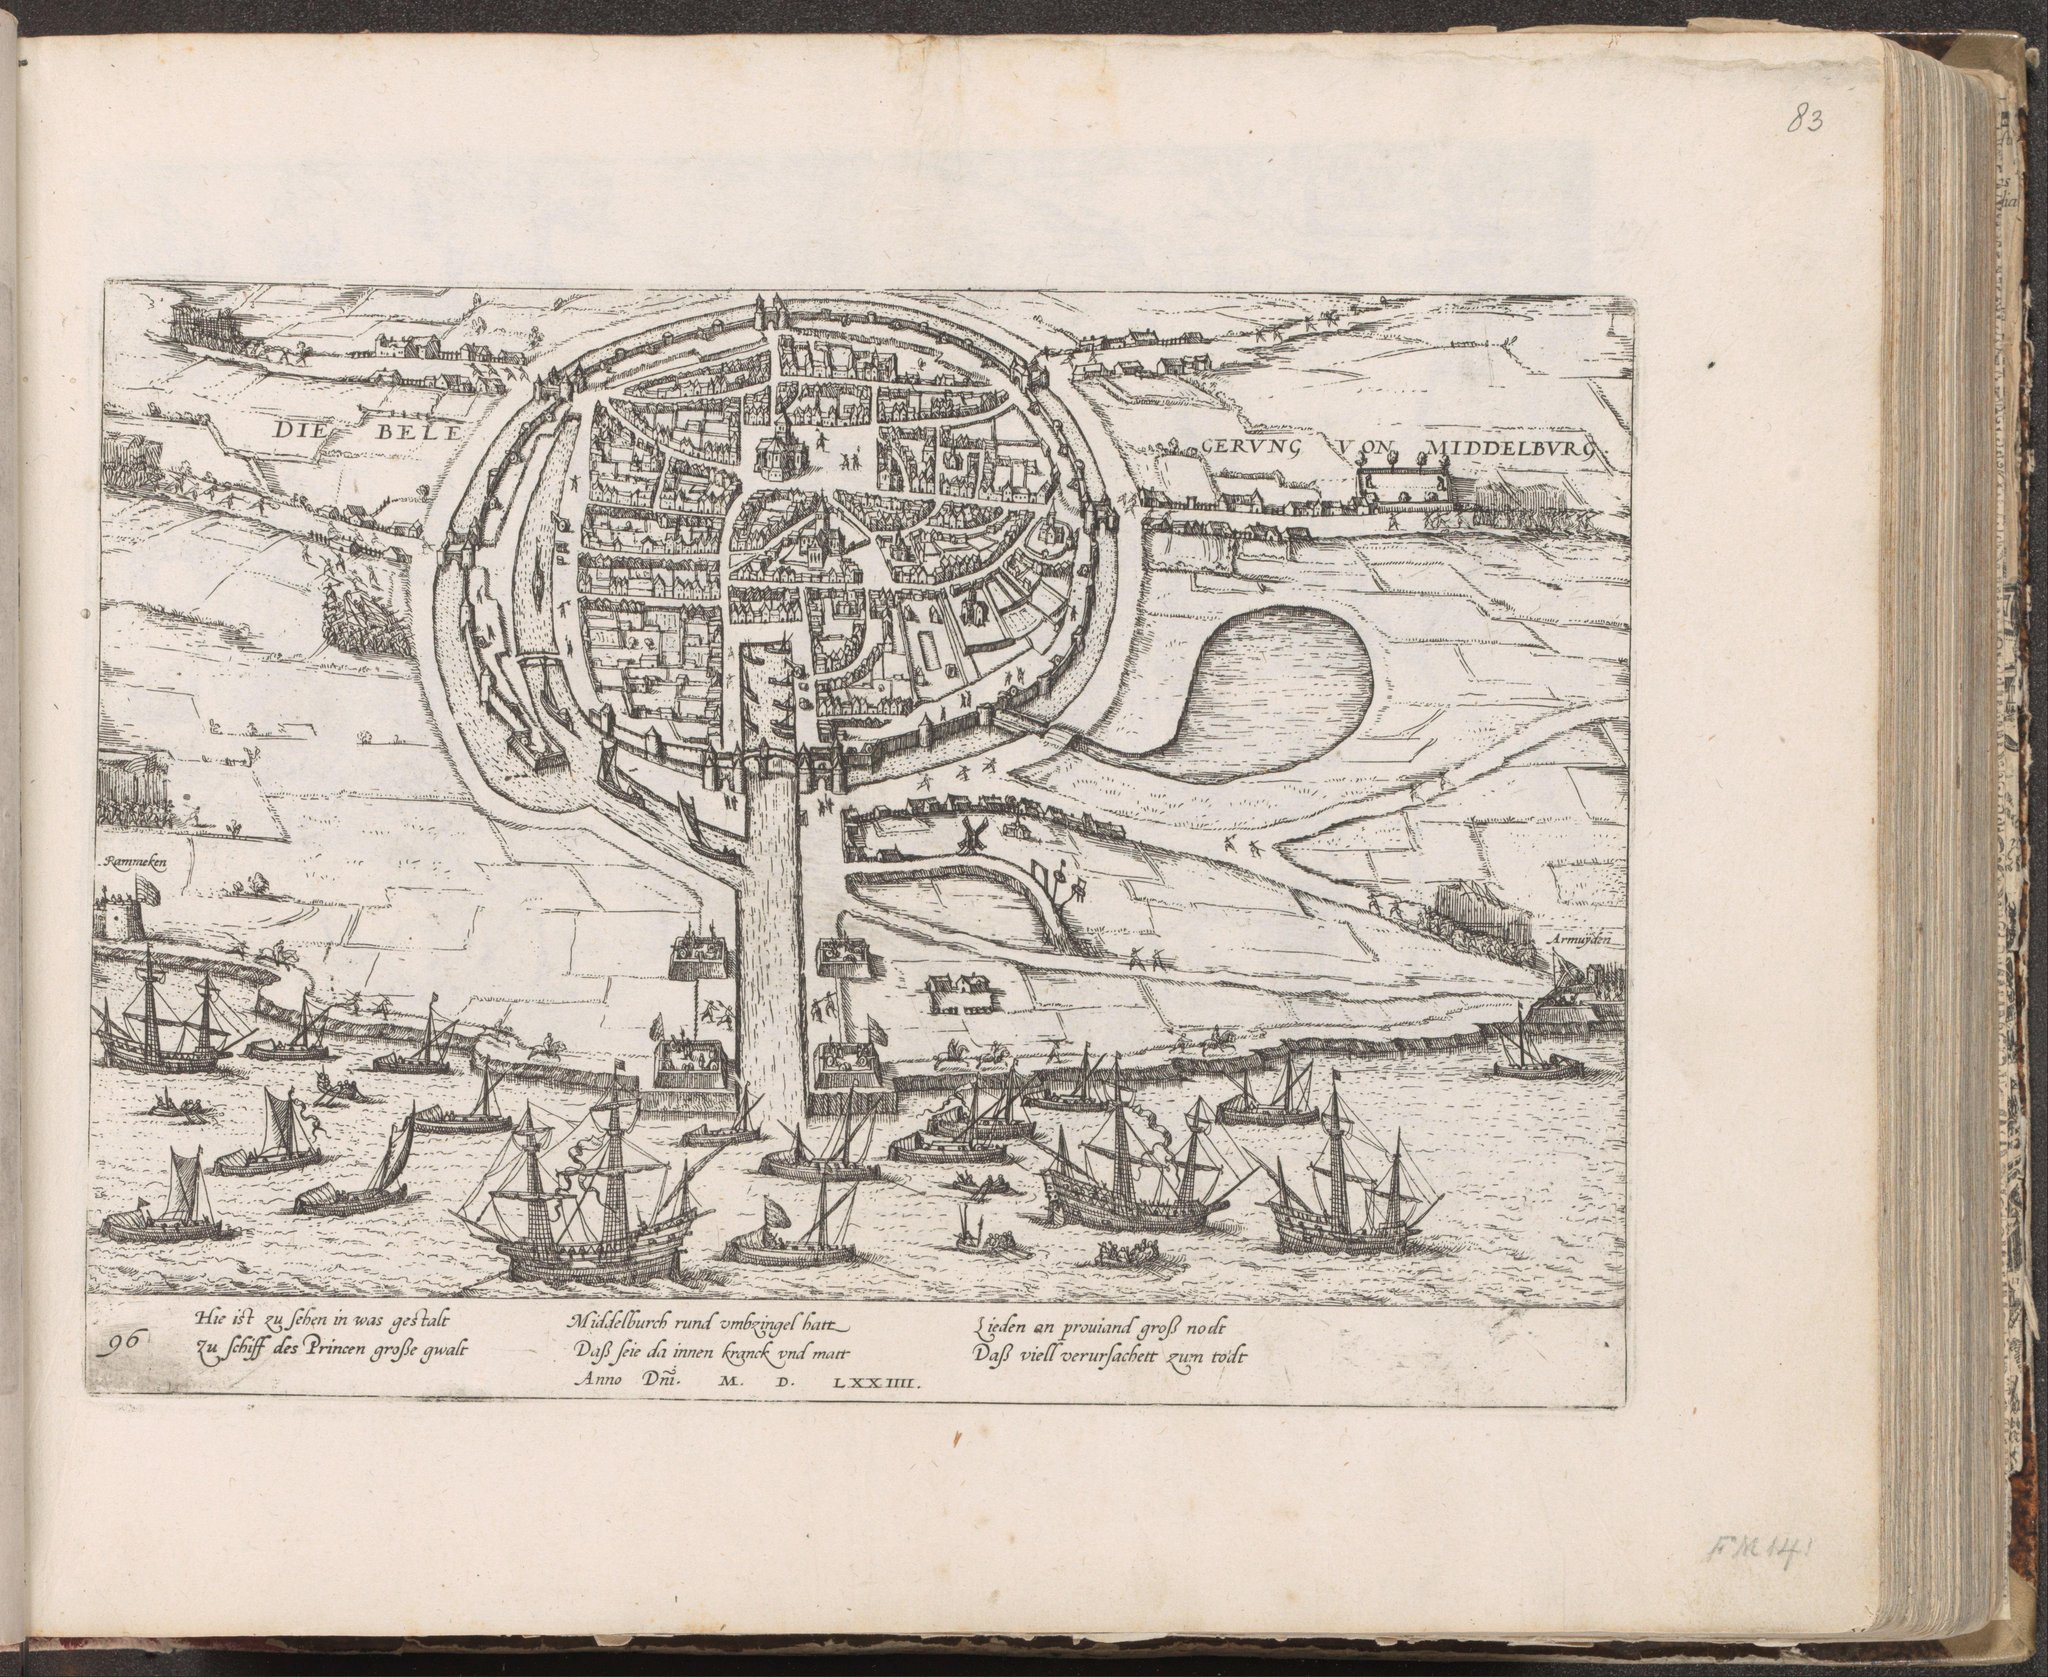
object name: print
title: Serie 6: Nederlandse Gebeurtenissen, 1571-1576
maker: frans hogenberg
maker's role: print maker, publisher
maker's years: 1538-1590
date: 1574-1578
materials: paper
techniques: etching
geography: cologne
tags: siege, position war, middelburg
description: Beleg van Middelburg door de opstandelingen, januari 1574. Gezicht op de belegerde stad en de omgeving. Op de voorgrond de schepen van de geuzen, Fort Rammekens en Arnemuiden. Met onderschrift van 6 regels in het Duits. Linksonder genummerd: 96. De prent maakt deel uit van een album.